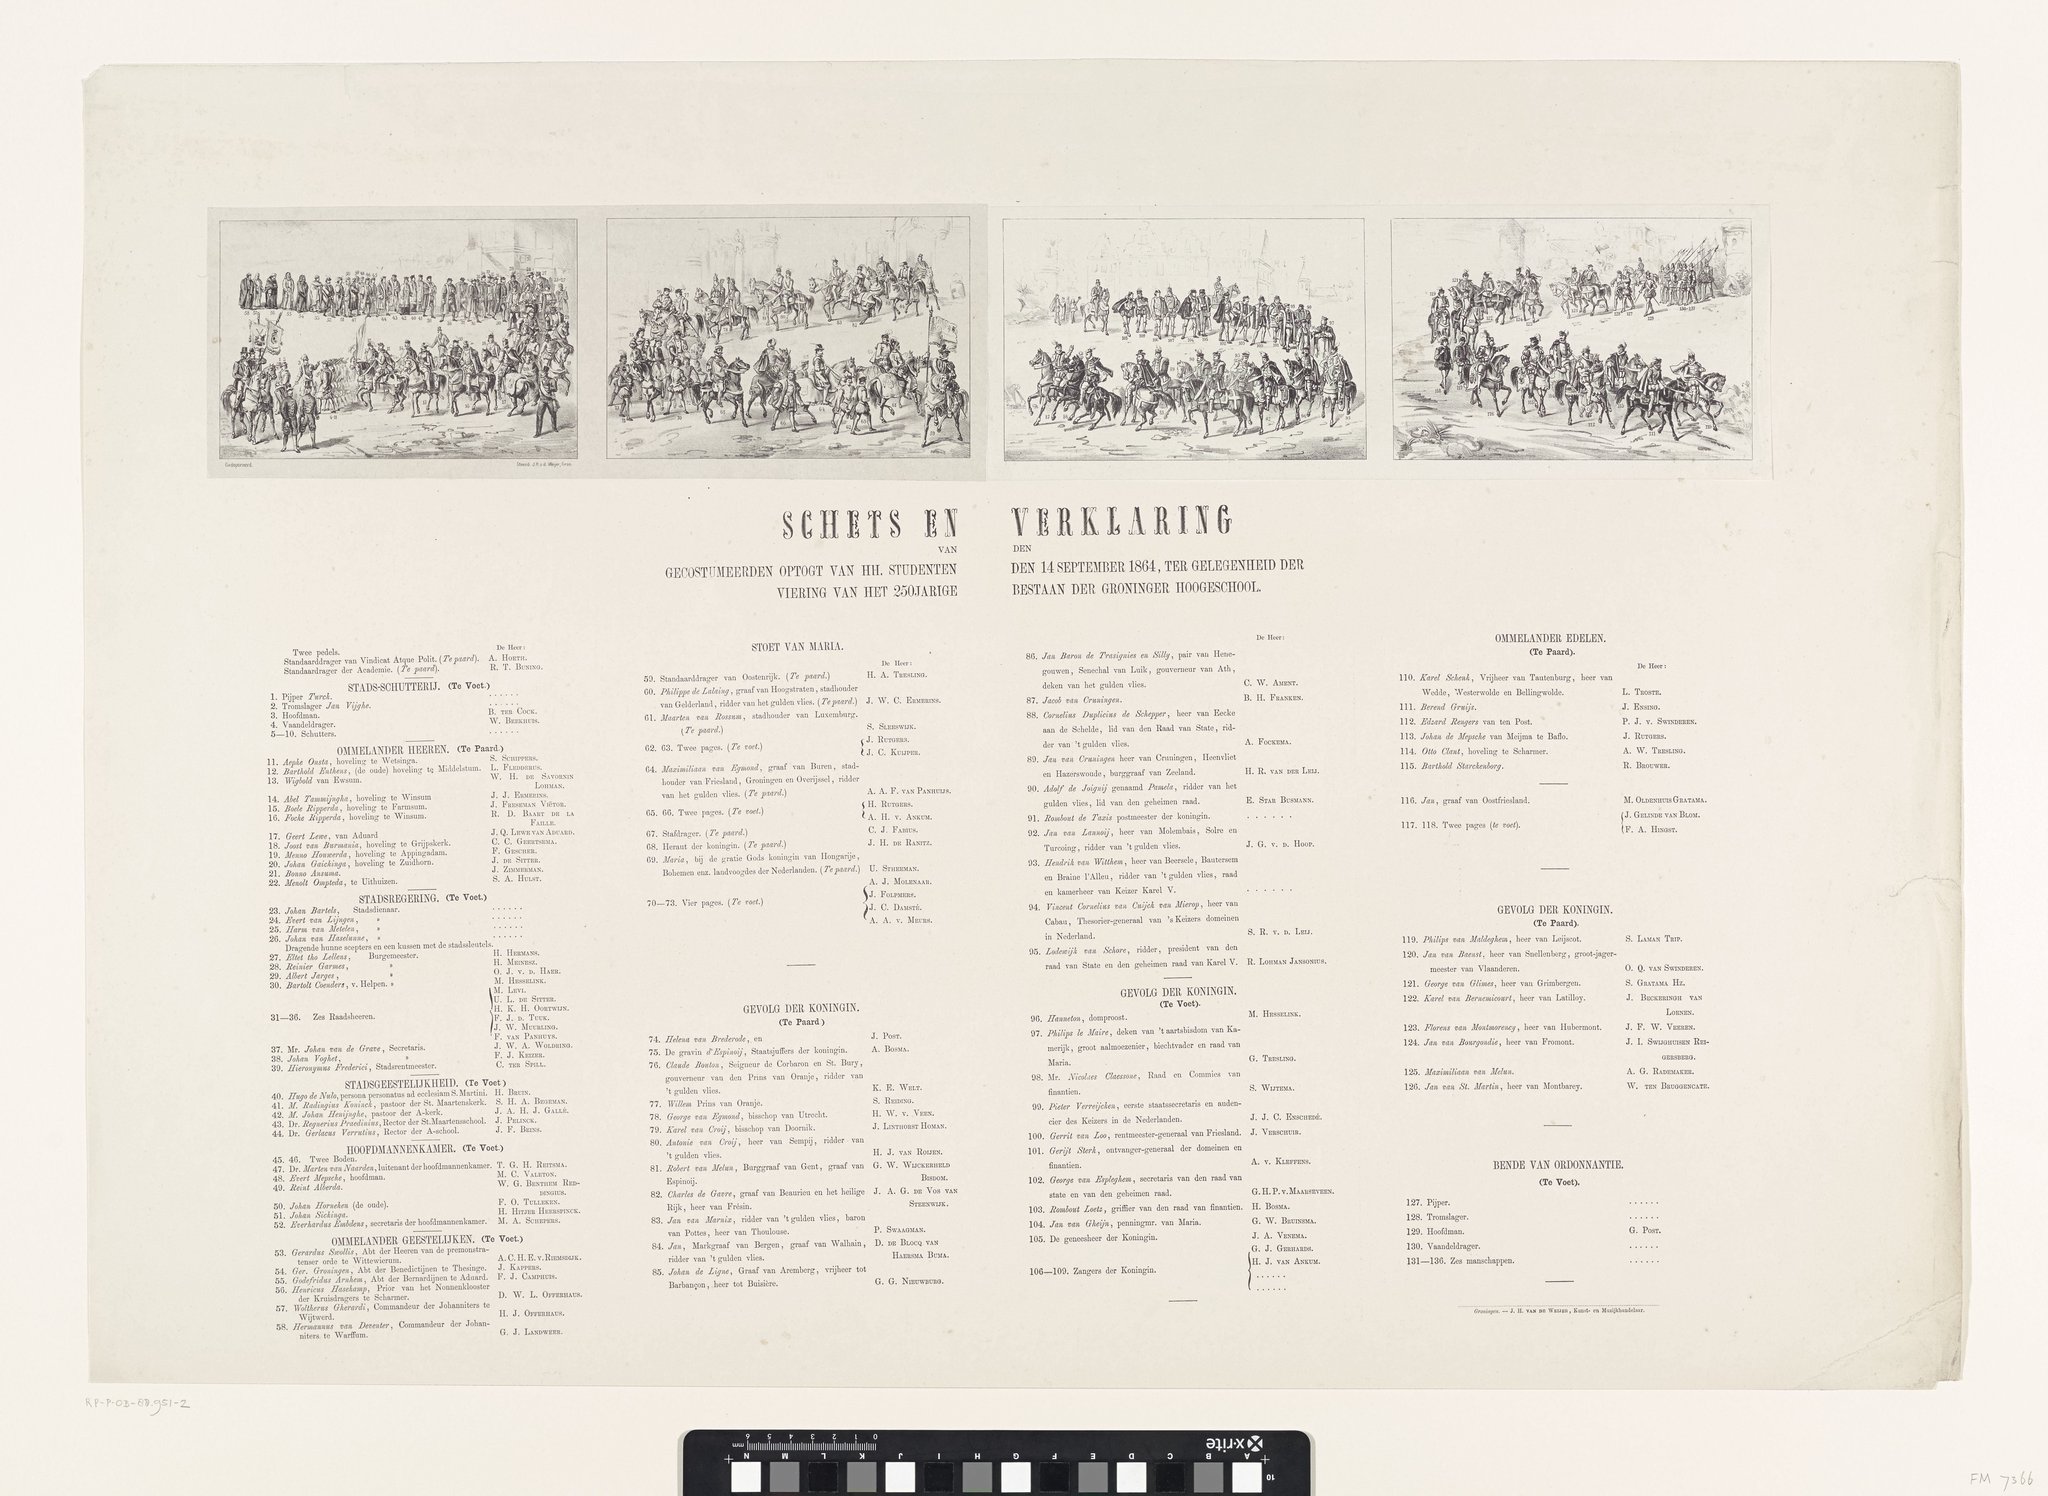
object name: print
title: Verklaring bij de prenten van de Groningse maskerade, 1864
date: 1864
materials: paper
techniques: letterpress printing, lithograph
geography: groningen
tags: brussels, maria van hongarije (landvoogdes der nederlanden), students' pageant, costumes used in pageants, commemoration of the founding of a university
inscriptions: collector's mark: Lugt 2228, : ‘Gedeponeerd’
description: Verklaring behorend bij de vier platen van de gekostumeerde optocht georganiseerd door de studenten van de Hogeschool van Groningen op 14 september 1864, ter viering van het 250-jarig bestaan van de hogeschool, voorstellende de intocht van Maria van Hongarije in Groningen op 20 juni 1545. Bovenaan twee bladen met de verkleinde kopieën van de vier platen op het blad geplakt, daaronder de legenda op de platen 1-136.